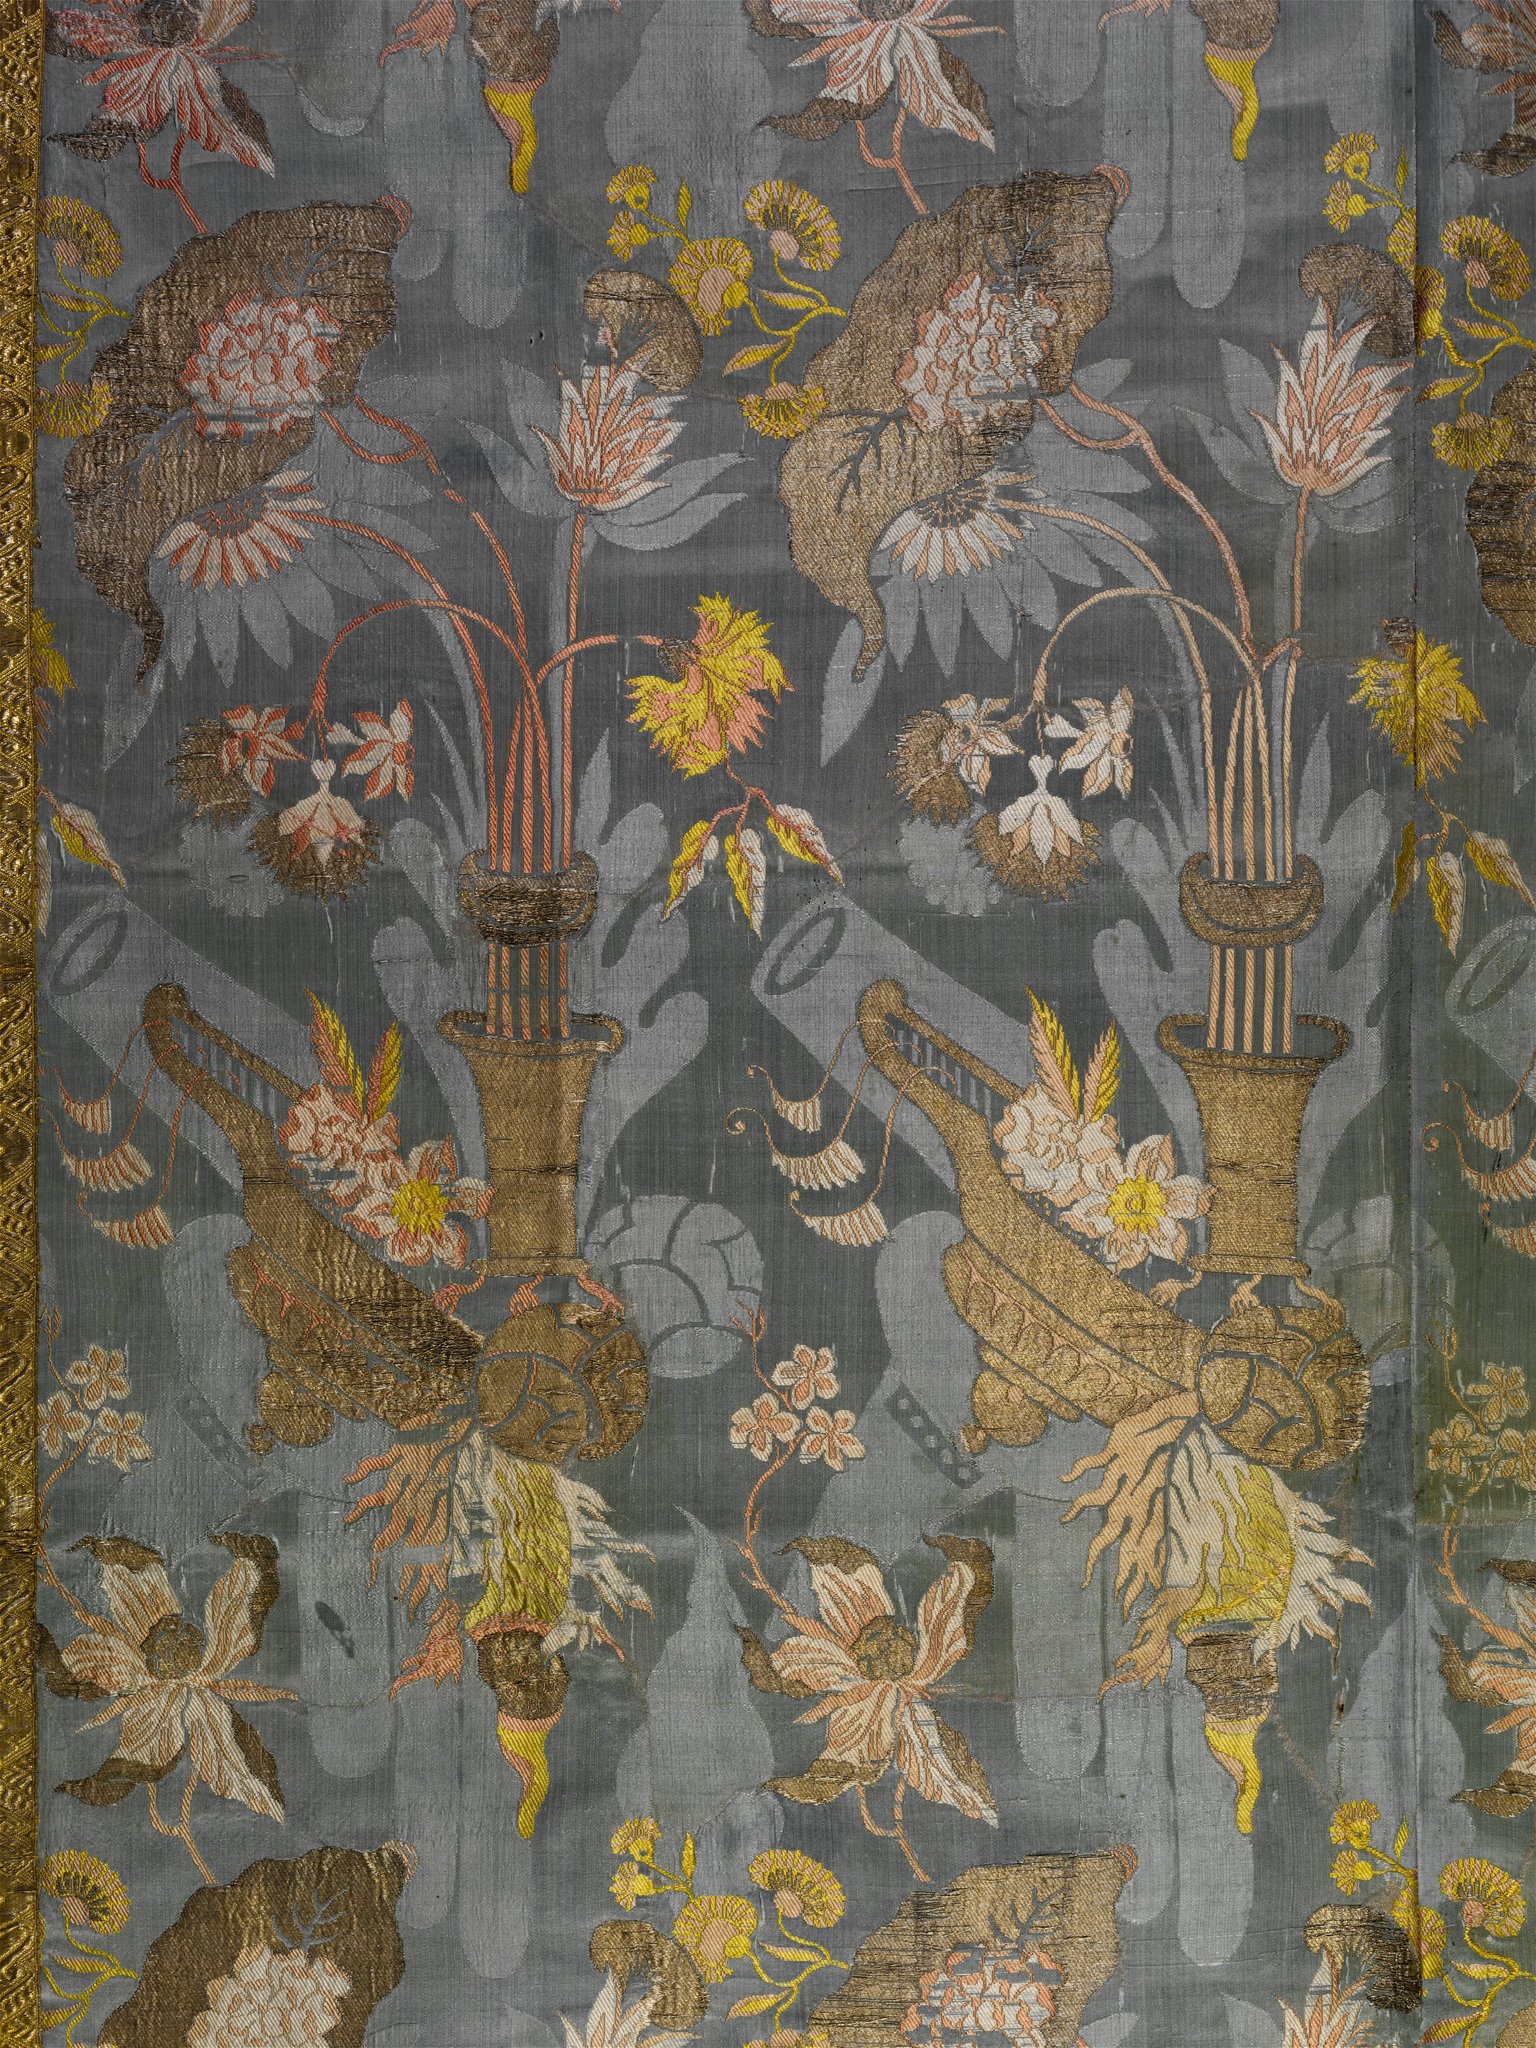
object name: piece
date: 1715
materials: metal thread, silk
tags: flowers,leaves